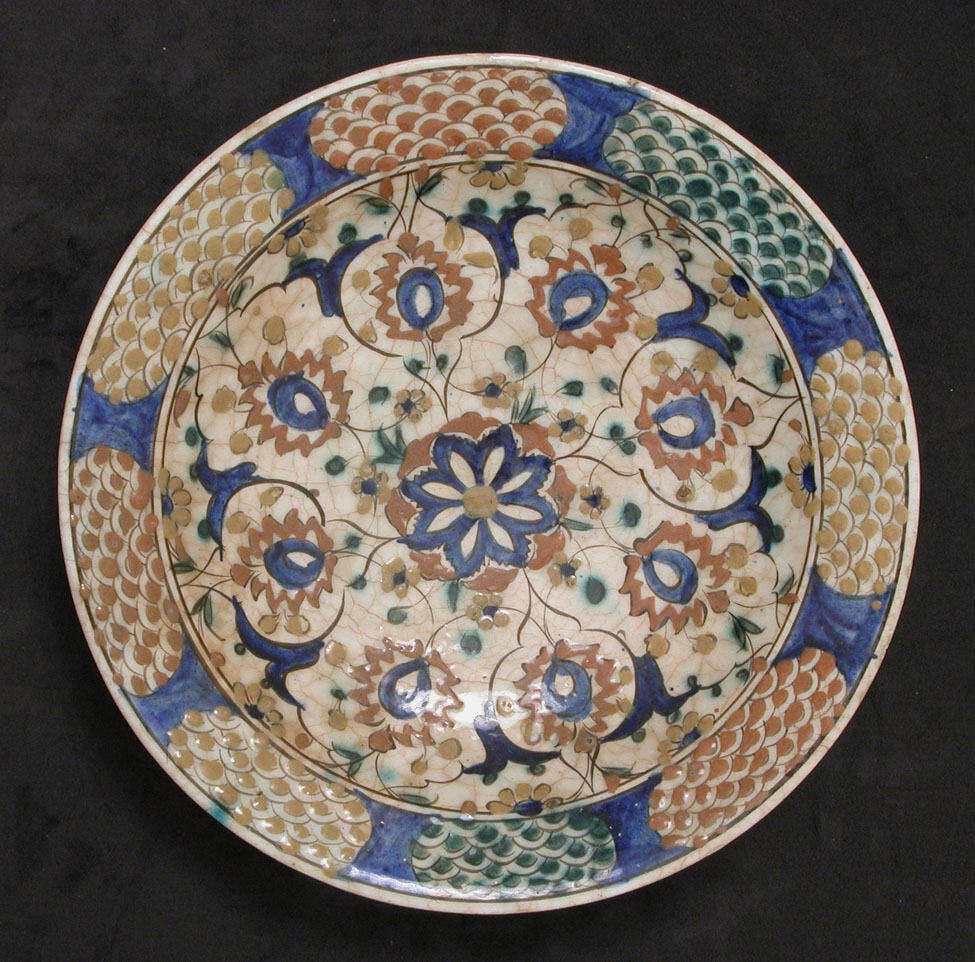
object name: dish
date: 1601-1650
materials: stonepaste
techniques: painting, underglaze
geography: iran